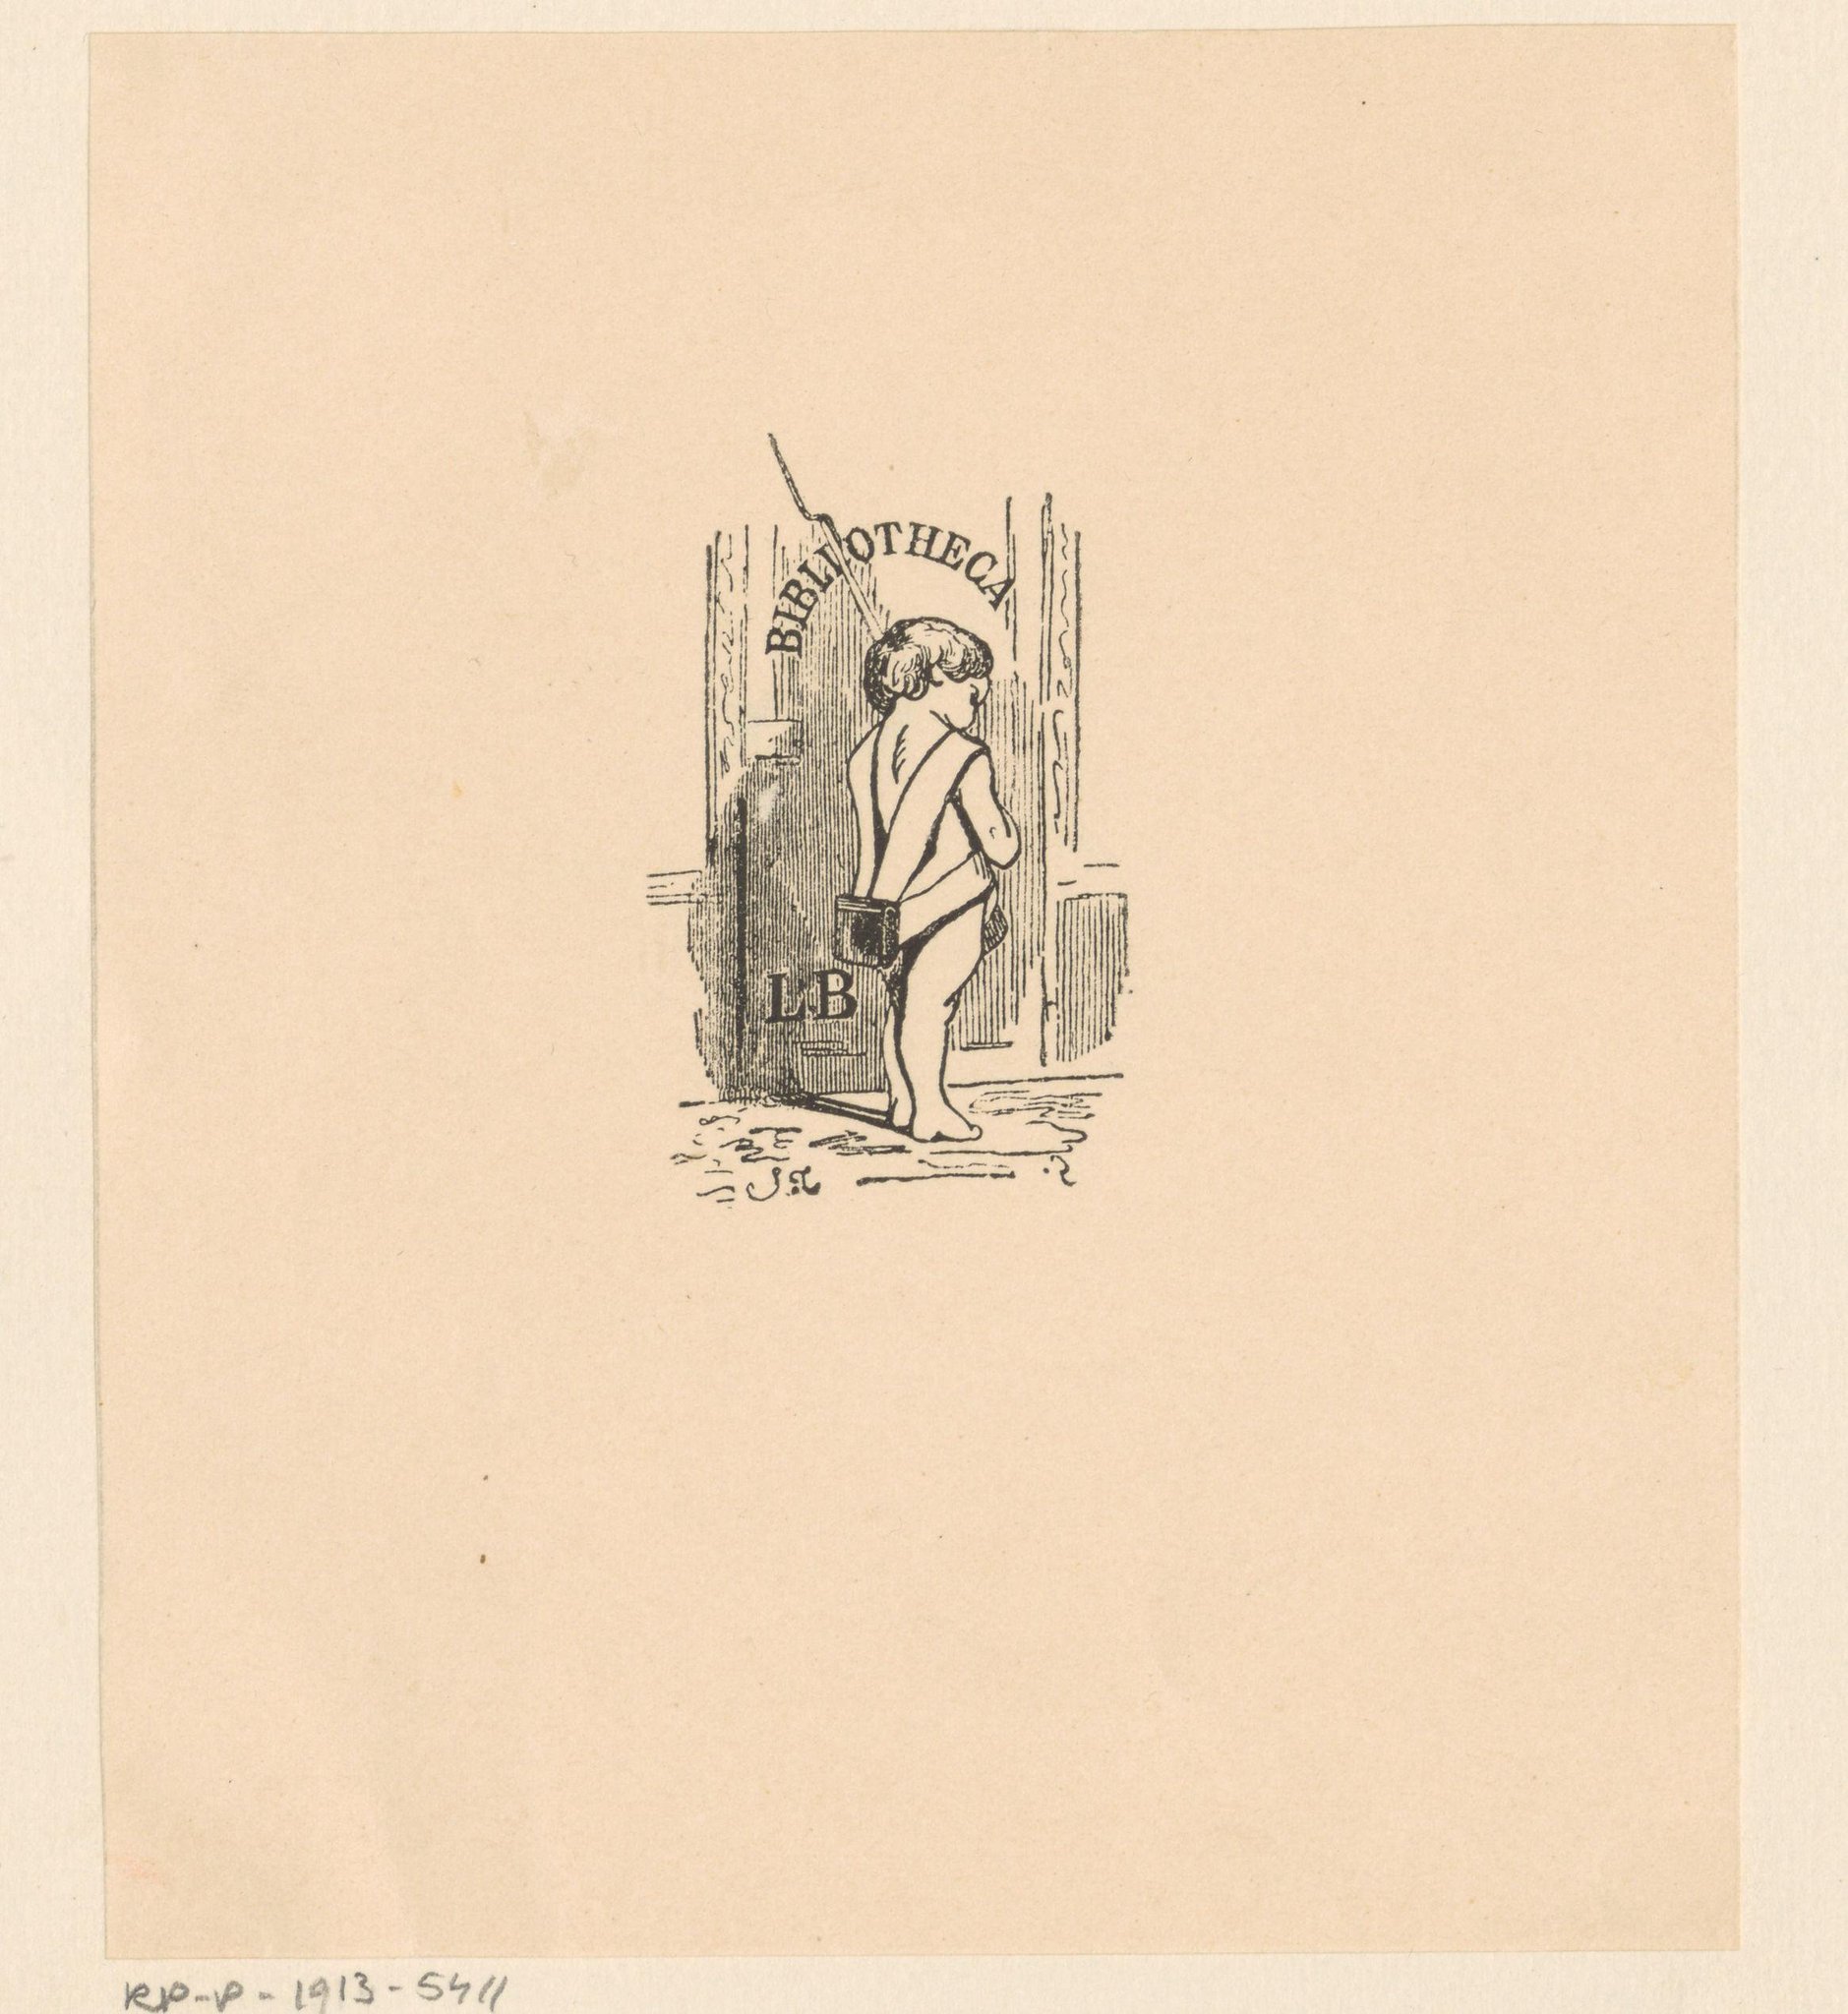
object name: bookplate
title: Bibliotheca L.B.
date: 1814-1866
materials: paper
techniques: printing block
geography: france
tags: helved weapons, polearms (for striking, hacking, thrusting) (with name), infant, baby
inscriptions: collector's mark: Lugt 2760, collector's mark: Lugt 2233